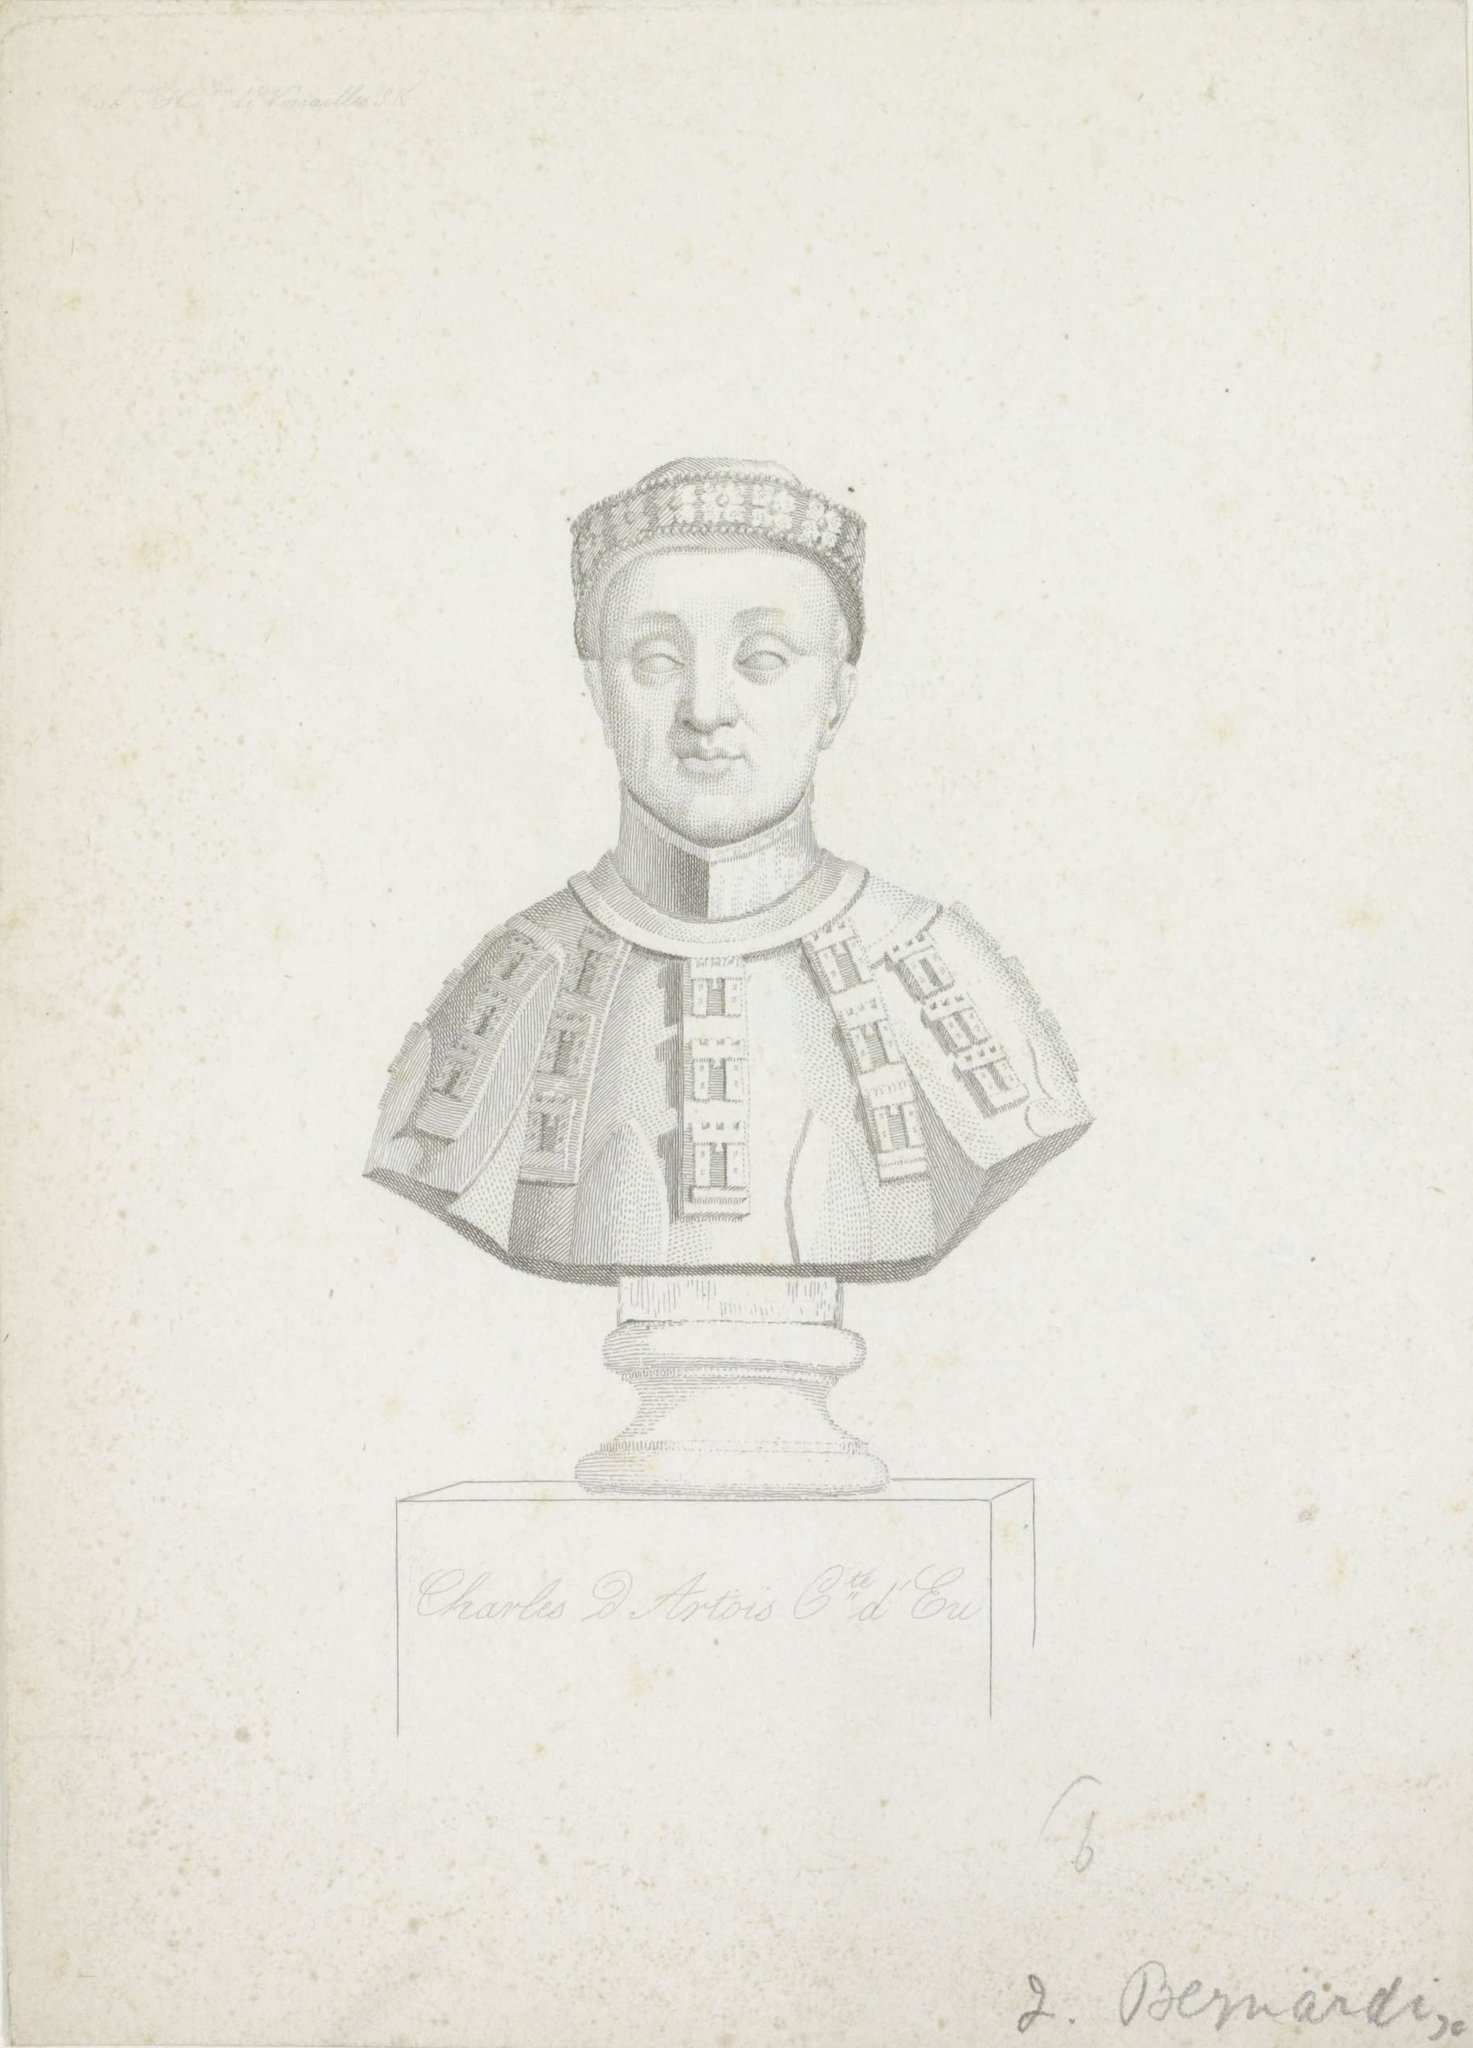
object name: print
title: Galerie historique de Versailles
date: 1818-1848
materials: paper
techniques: engraving, etching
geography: paris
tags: earl, historical persons, piece of sculpture, reproduction of a piece of sculpture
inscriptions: collector's mark: Lugt 2228